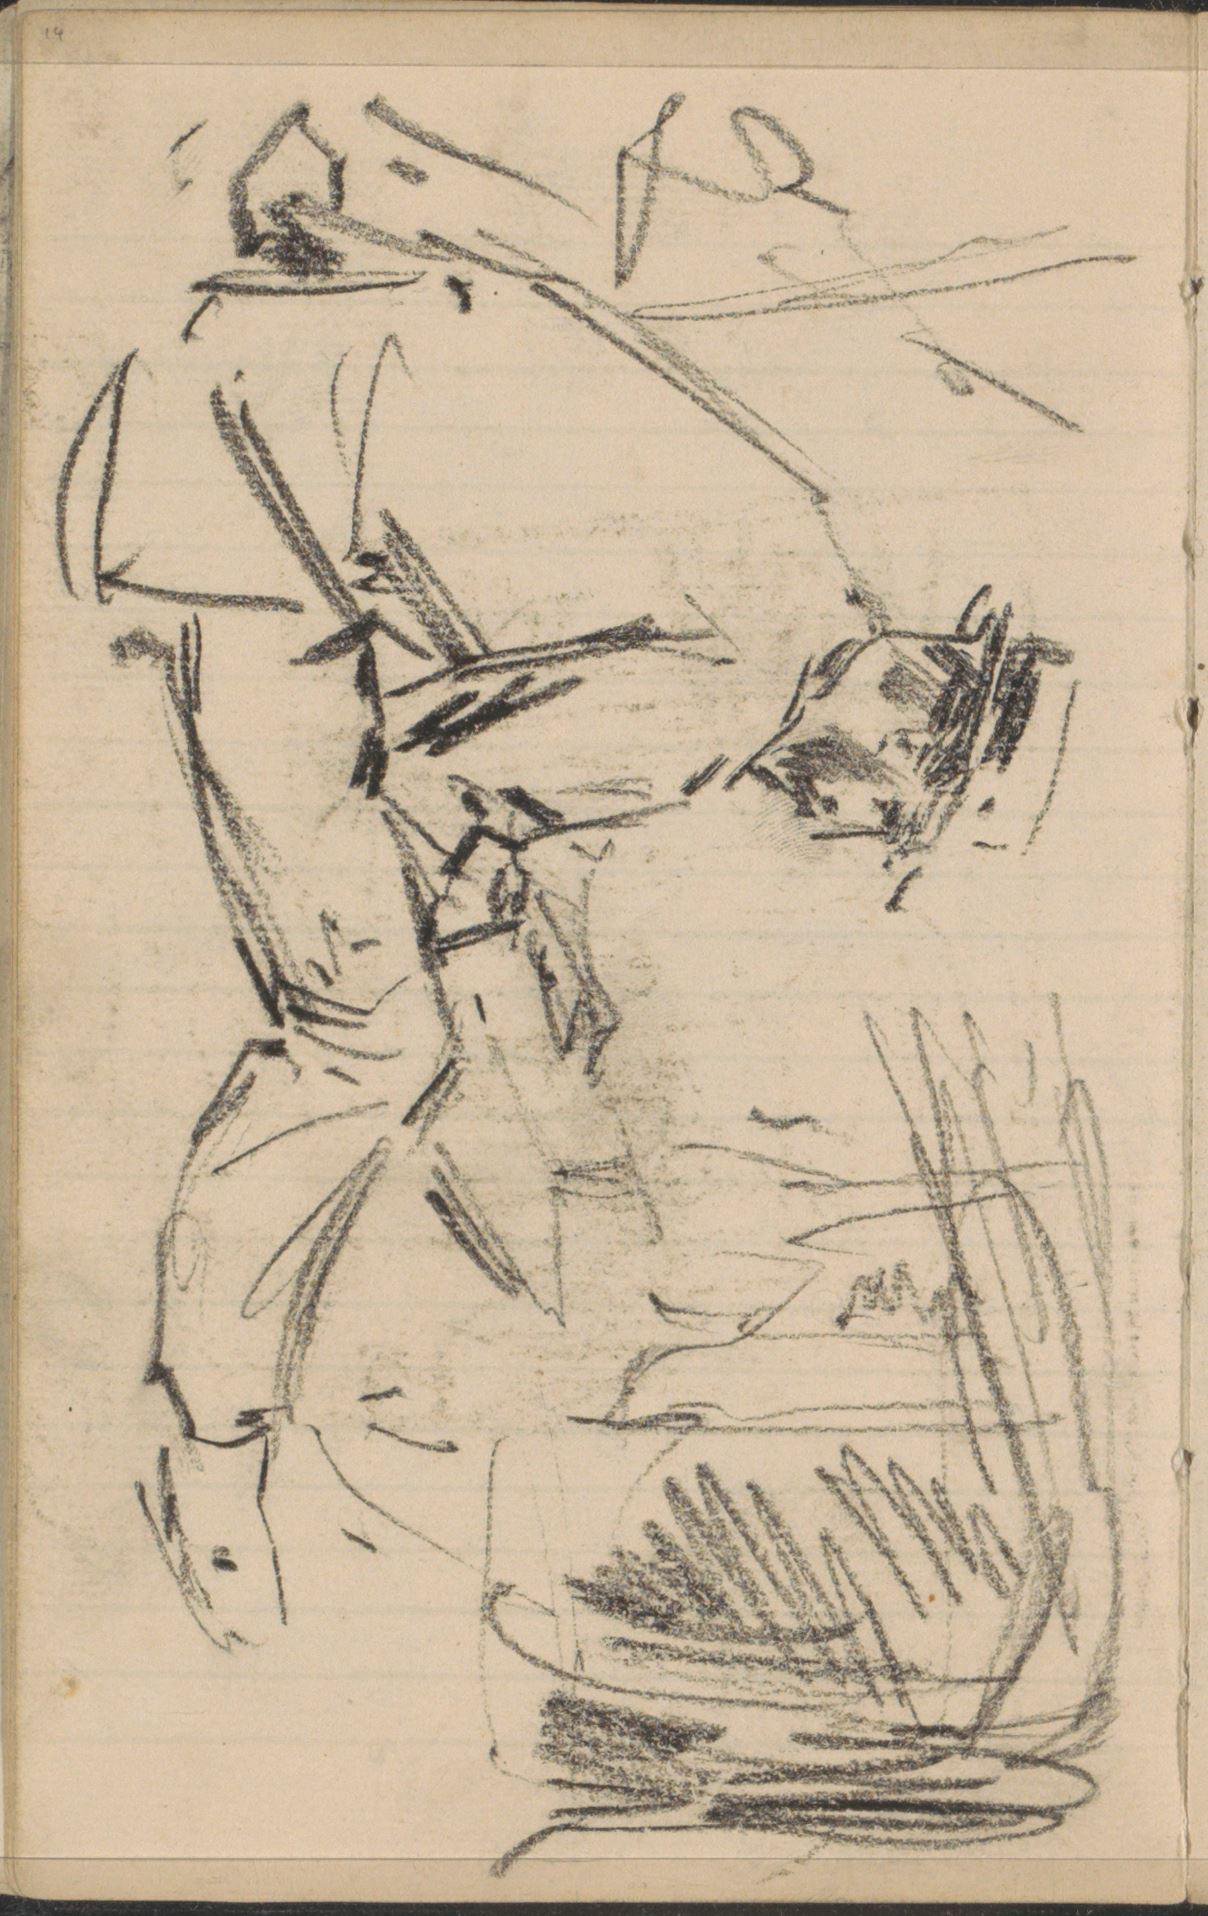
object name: sketchbook leaf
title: Zittende man met boek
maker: marius bauer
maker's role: draughtsman, print maker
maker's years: 1867-1932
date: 1881-1885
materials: chalk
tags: sitting figure, adult man, book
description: De man is zittend en van opzij getekend met een boek, mogelijk een schetsboek, in de hand. Pagina 14 uit een schetsboek met 26 bladen.